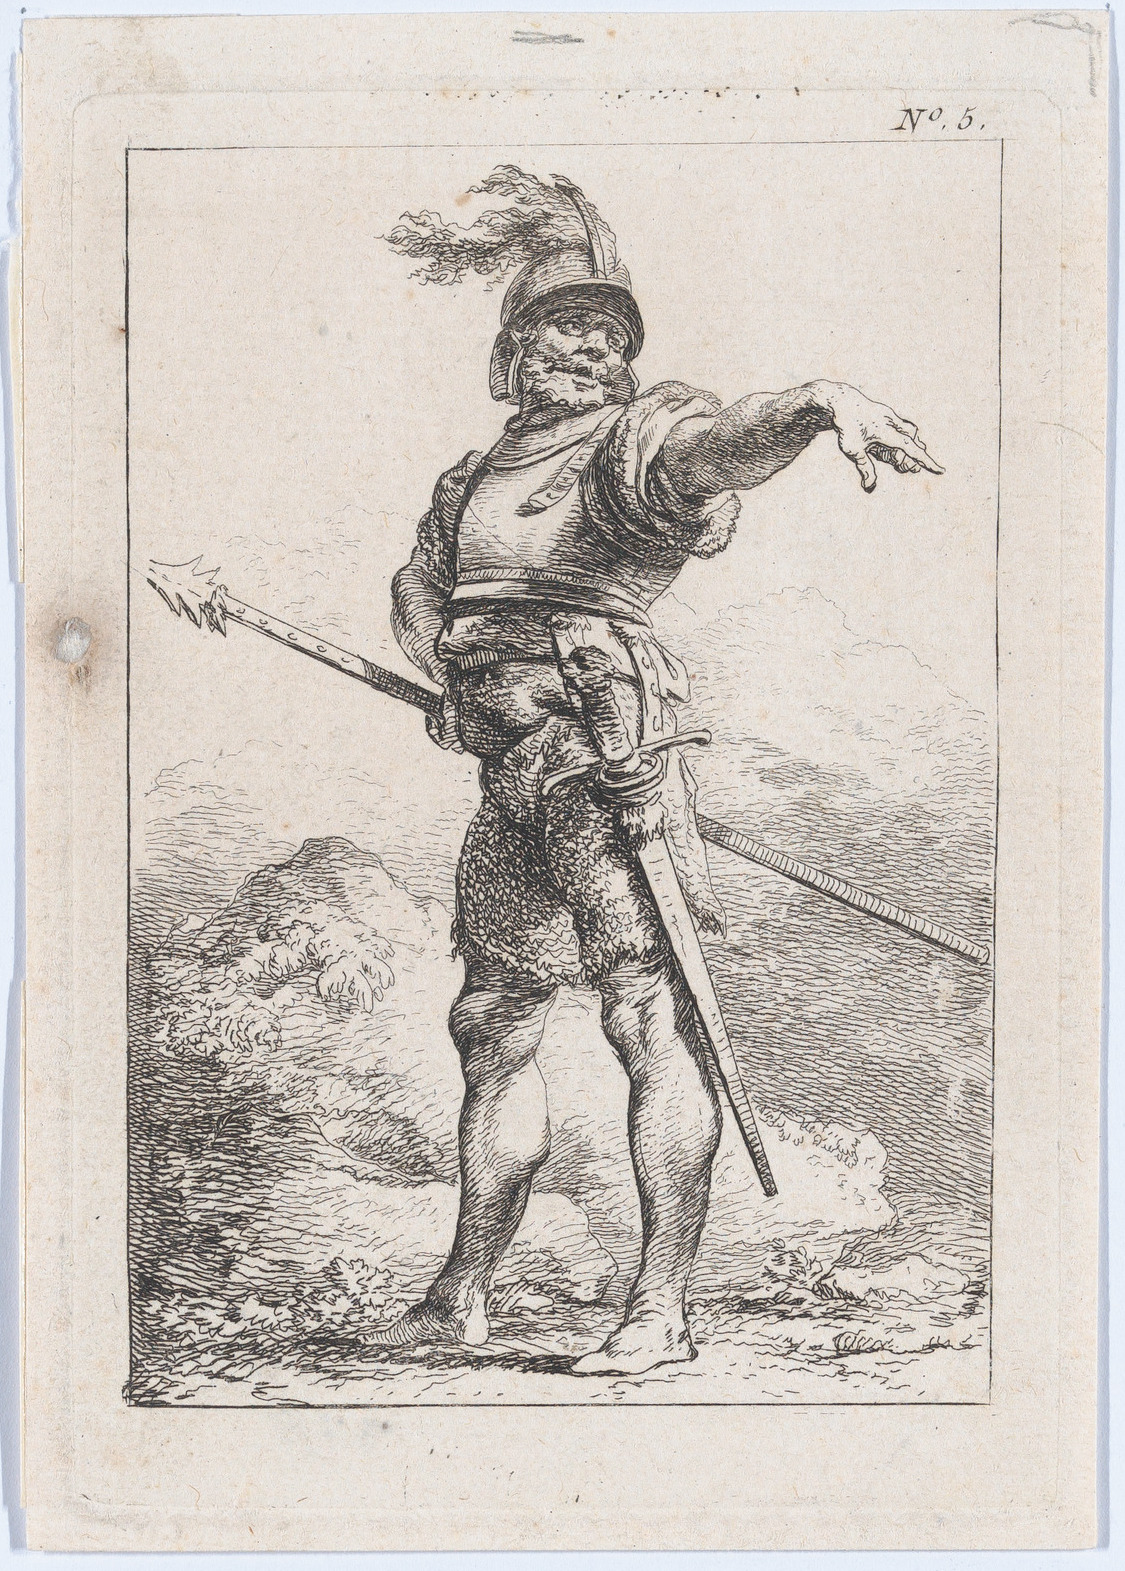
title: Standing Officer Holding a Lance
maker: philippe jacques de loutherbourg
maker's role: artist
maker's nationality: french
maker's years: 1740-1812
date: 1755-1771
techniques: etching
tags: soldiers,men